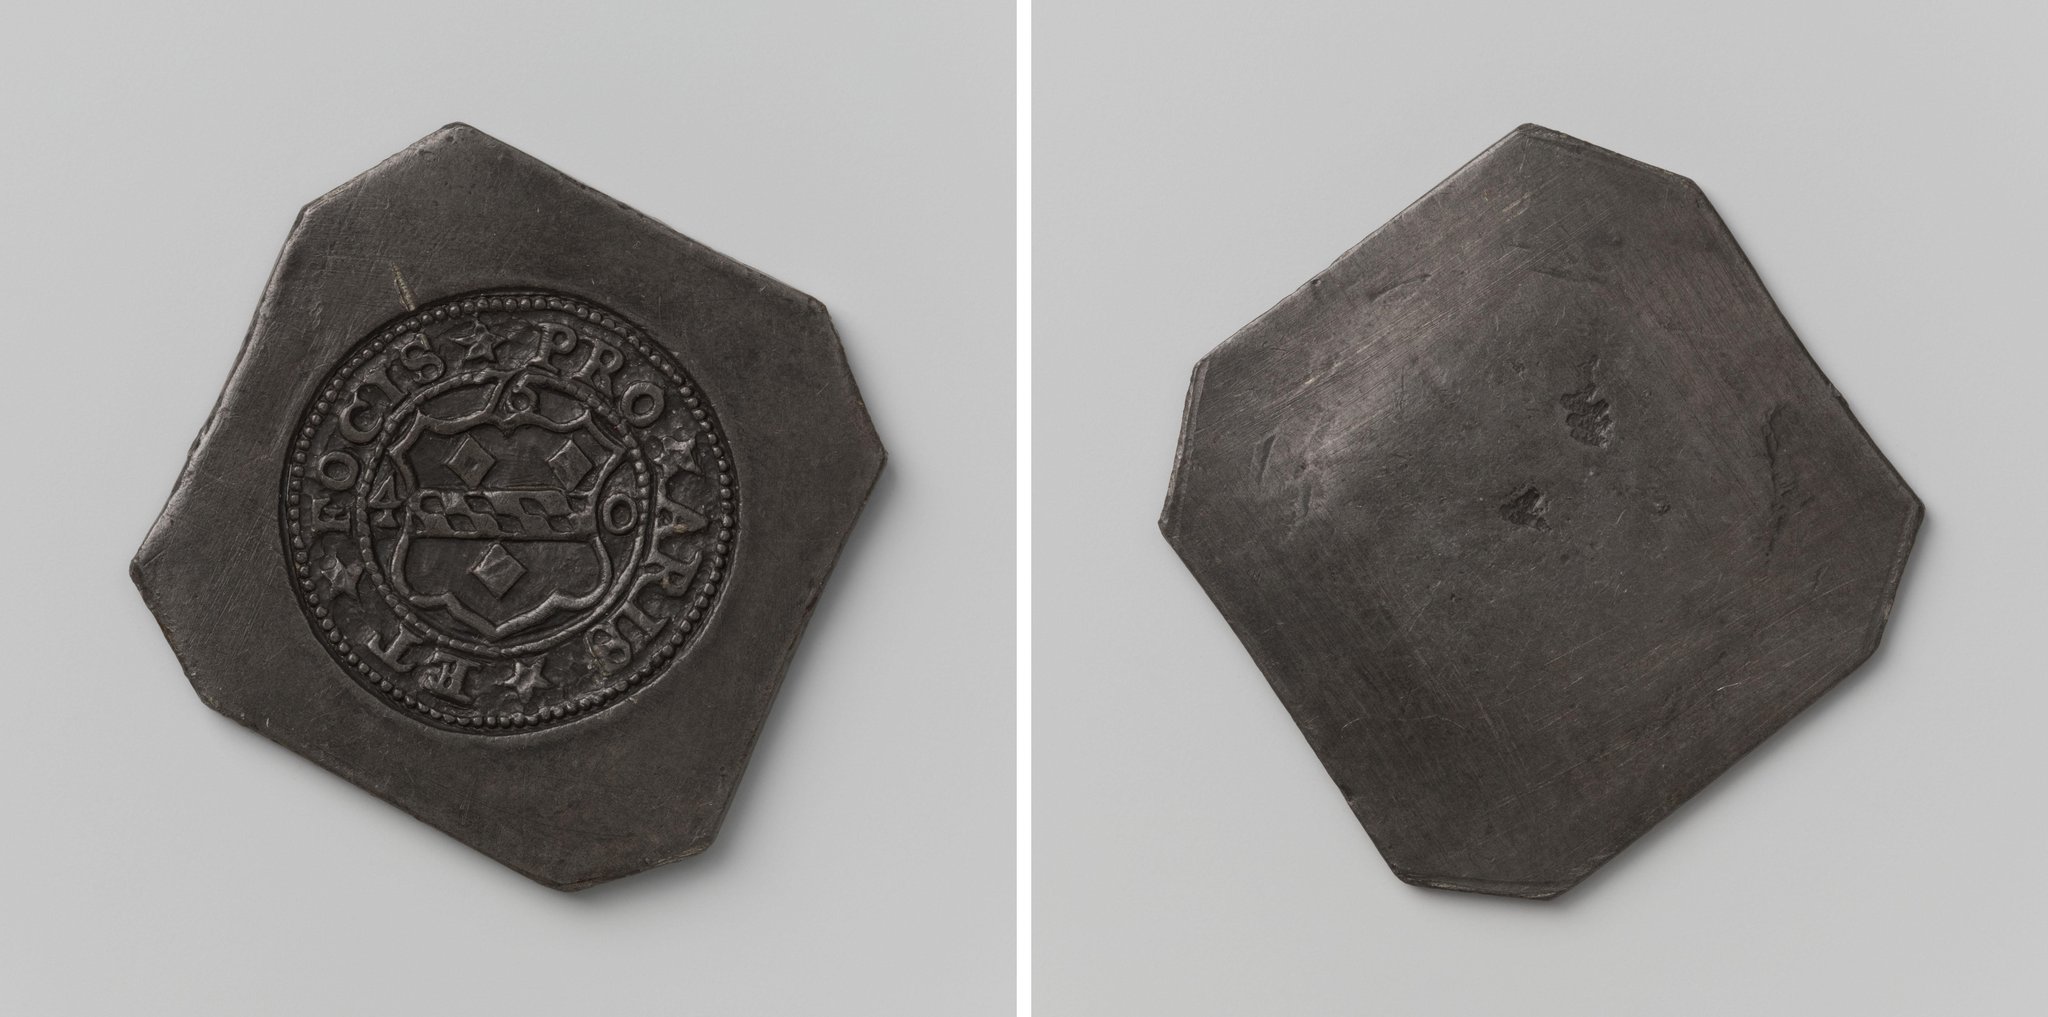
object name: coin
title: Veertig stuiver (vals), noodmunt uit Woerden, kopie van een noodmunt geslagen tijdens het beleg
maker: Anonymous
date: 1883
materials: tin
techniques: striking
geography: woerden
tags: woerden, tachtigjarige oorlog, beleg van woerden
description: eenzijdige, ruitvormige noodmunt met afgeschuinde hoeken. Voorzijde: wapenschild tussen cijfers 4 en 0 onder cijfers 7en 5 binnen omschrift en parelrand. Keerzijde: blanco